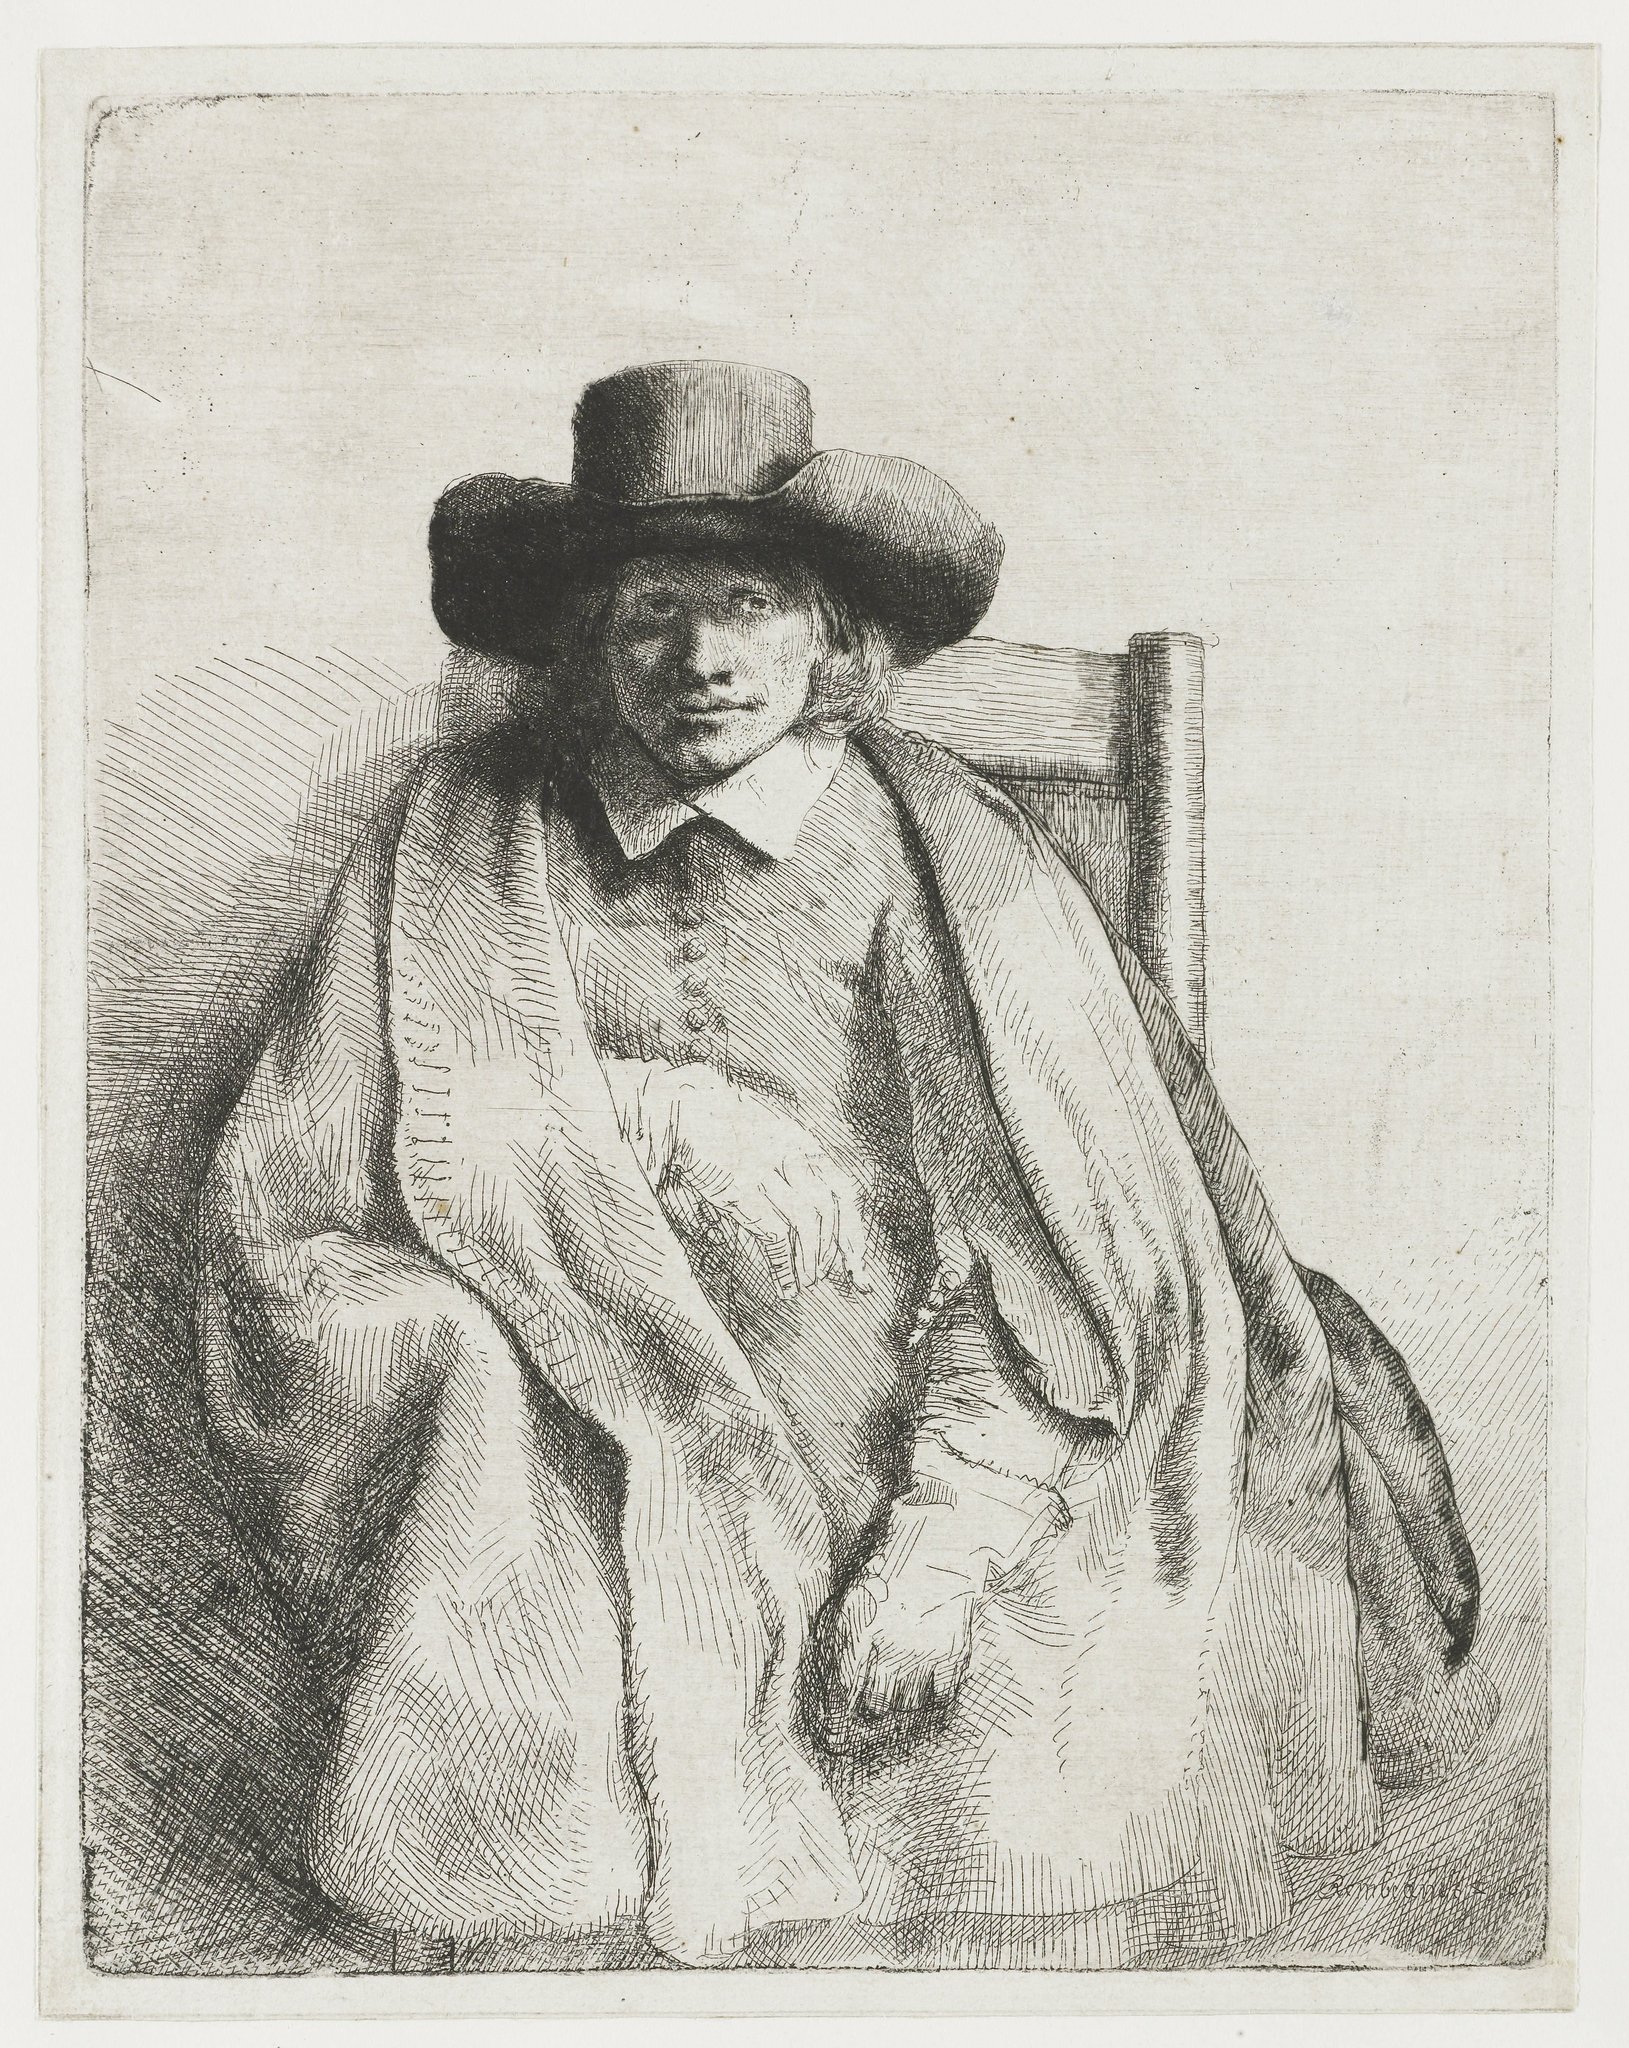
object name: print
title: Clement de Jonghe, printseller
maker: rembrandt van rijn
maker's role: draughtsman, painter, print maker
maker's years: 1606-1669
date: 1651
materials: paper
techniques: drypoint, etching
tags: germany, amsterdam, print maker, publisher, clement de jonghe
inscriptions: signature and date: ‘Rembrandt f 1651’, collector's mark: Lugt 240